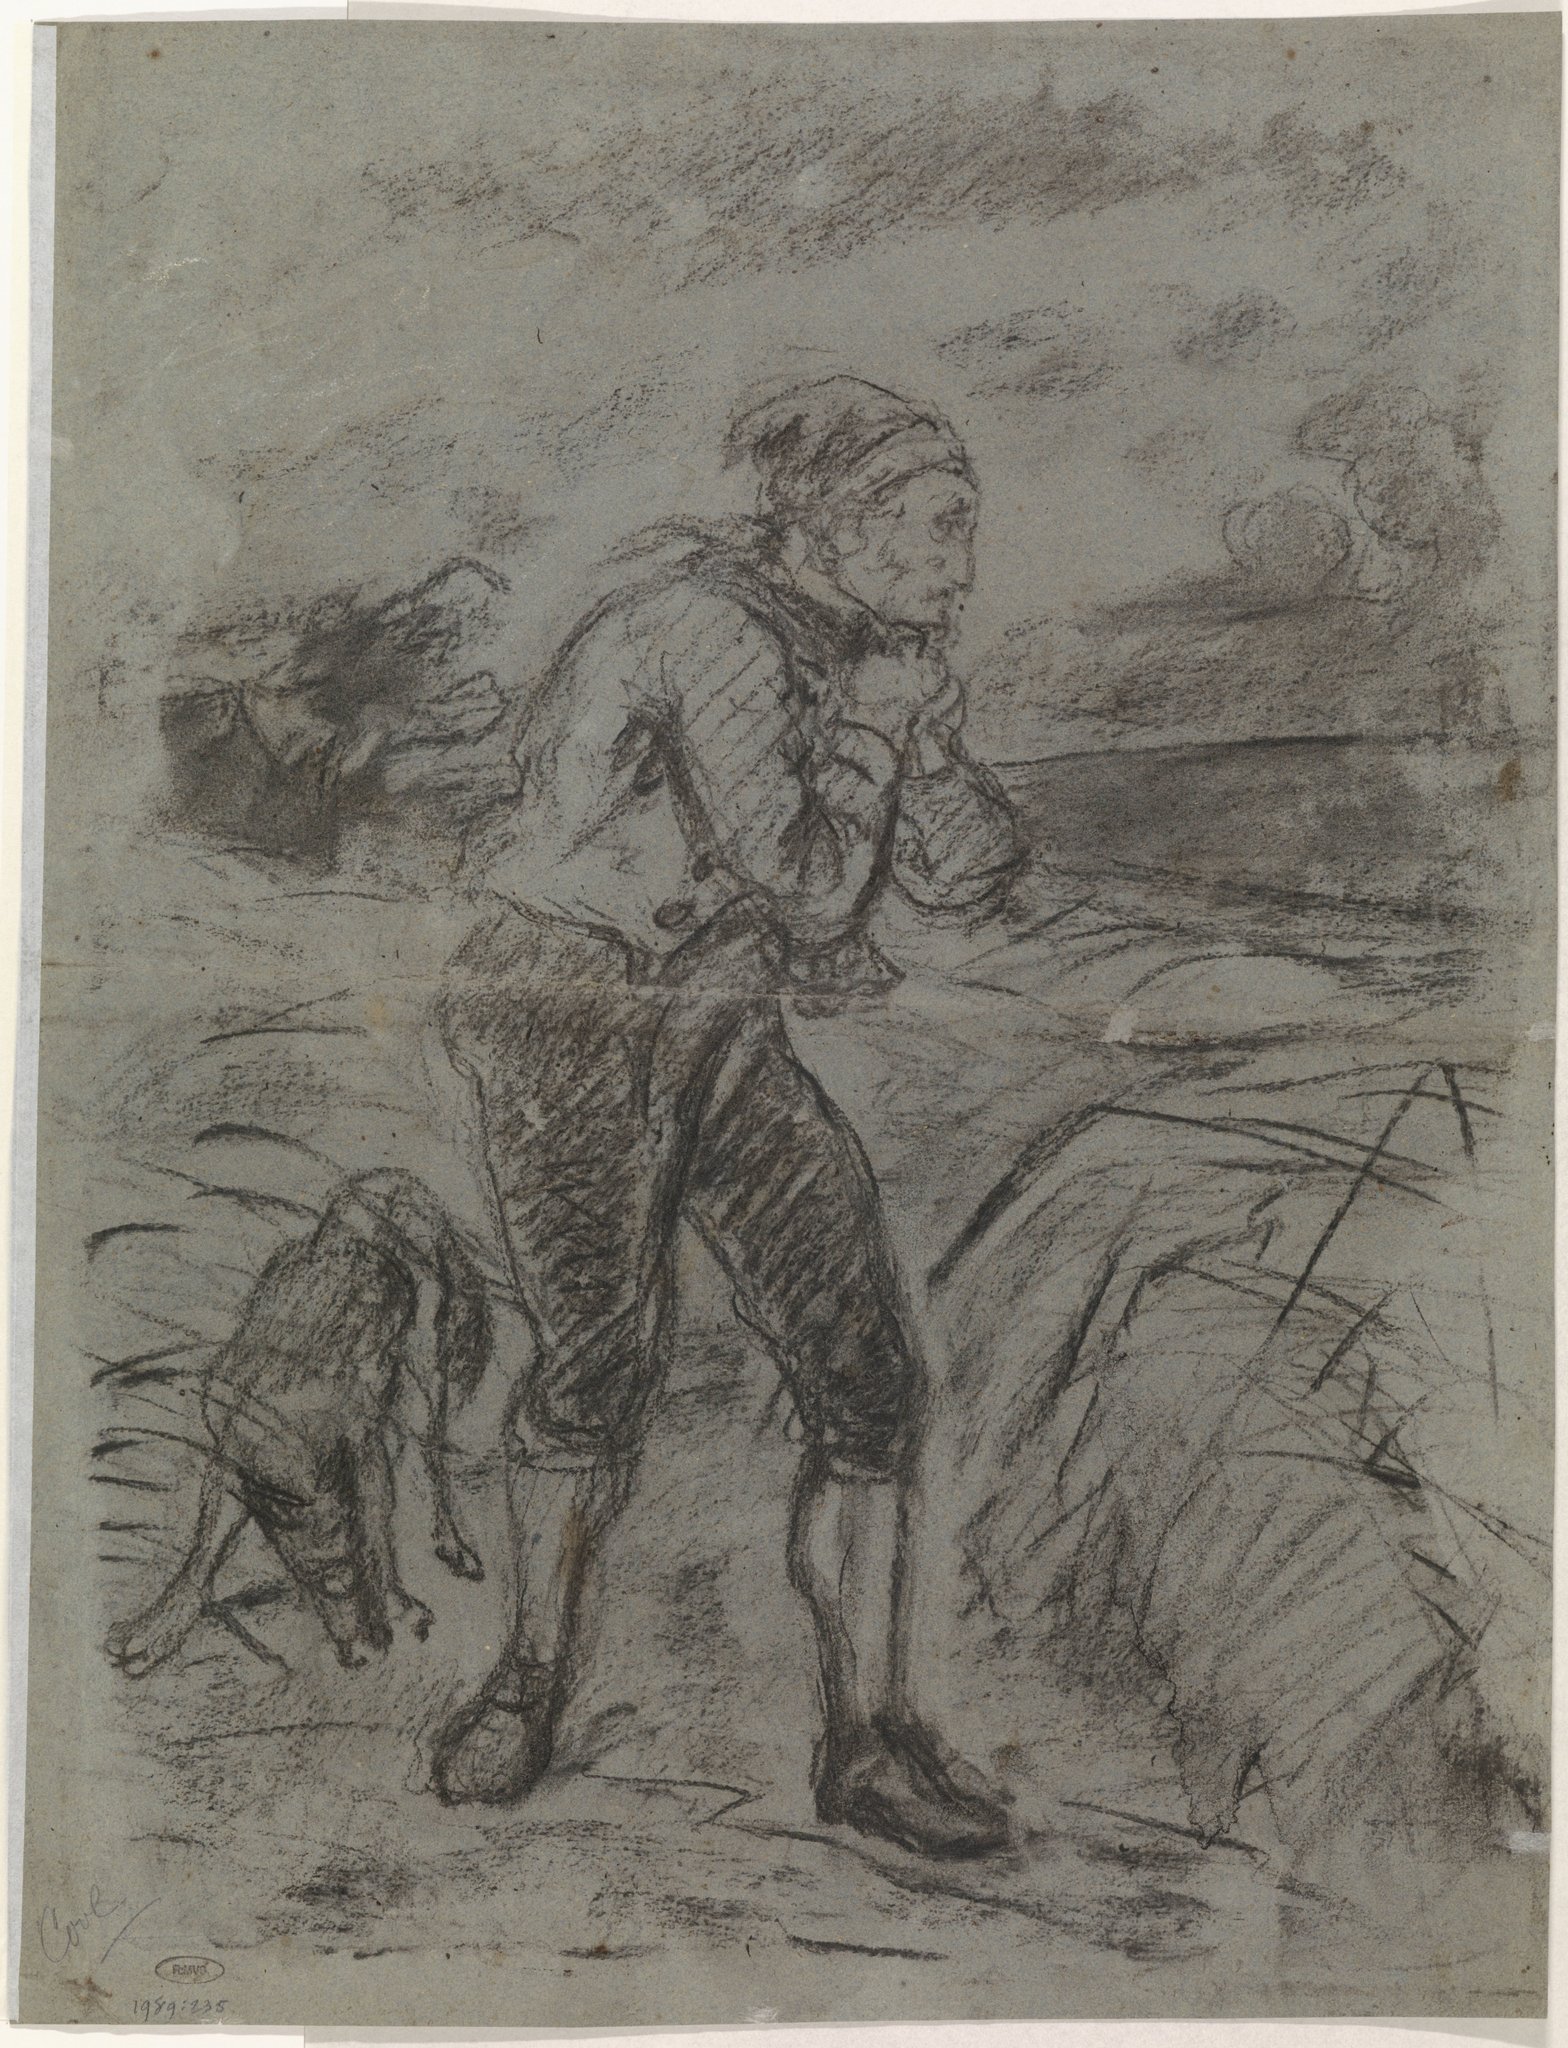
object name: drawing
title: Staande boer en zijn hond op de akker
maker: thomas simon cool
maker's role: draughtsman, print maker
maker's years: 1831-1870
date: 1841-1870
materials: chalk, paper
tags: dog